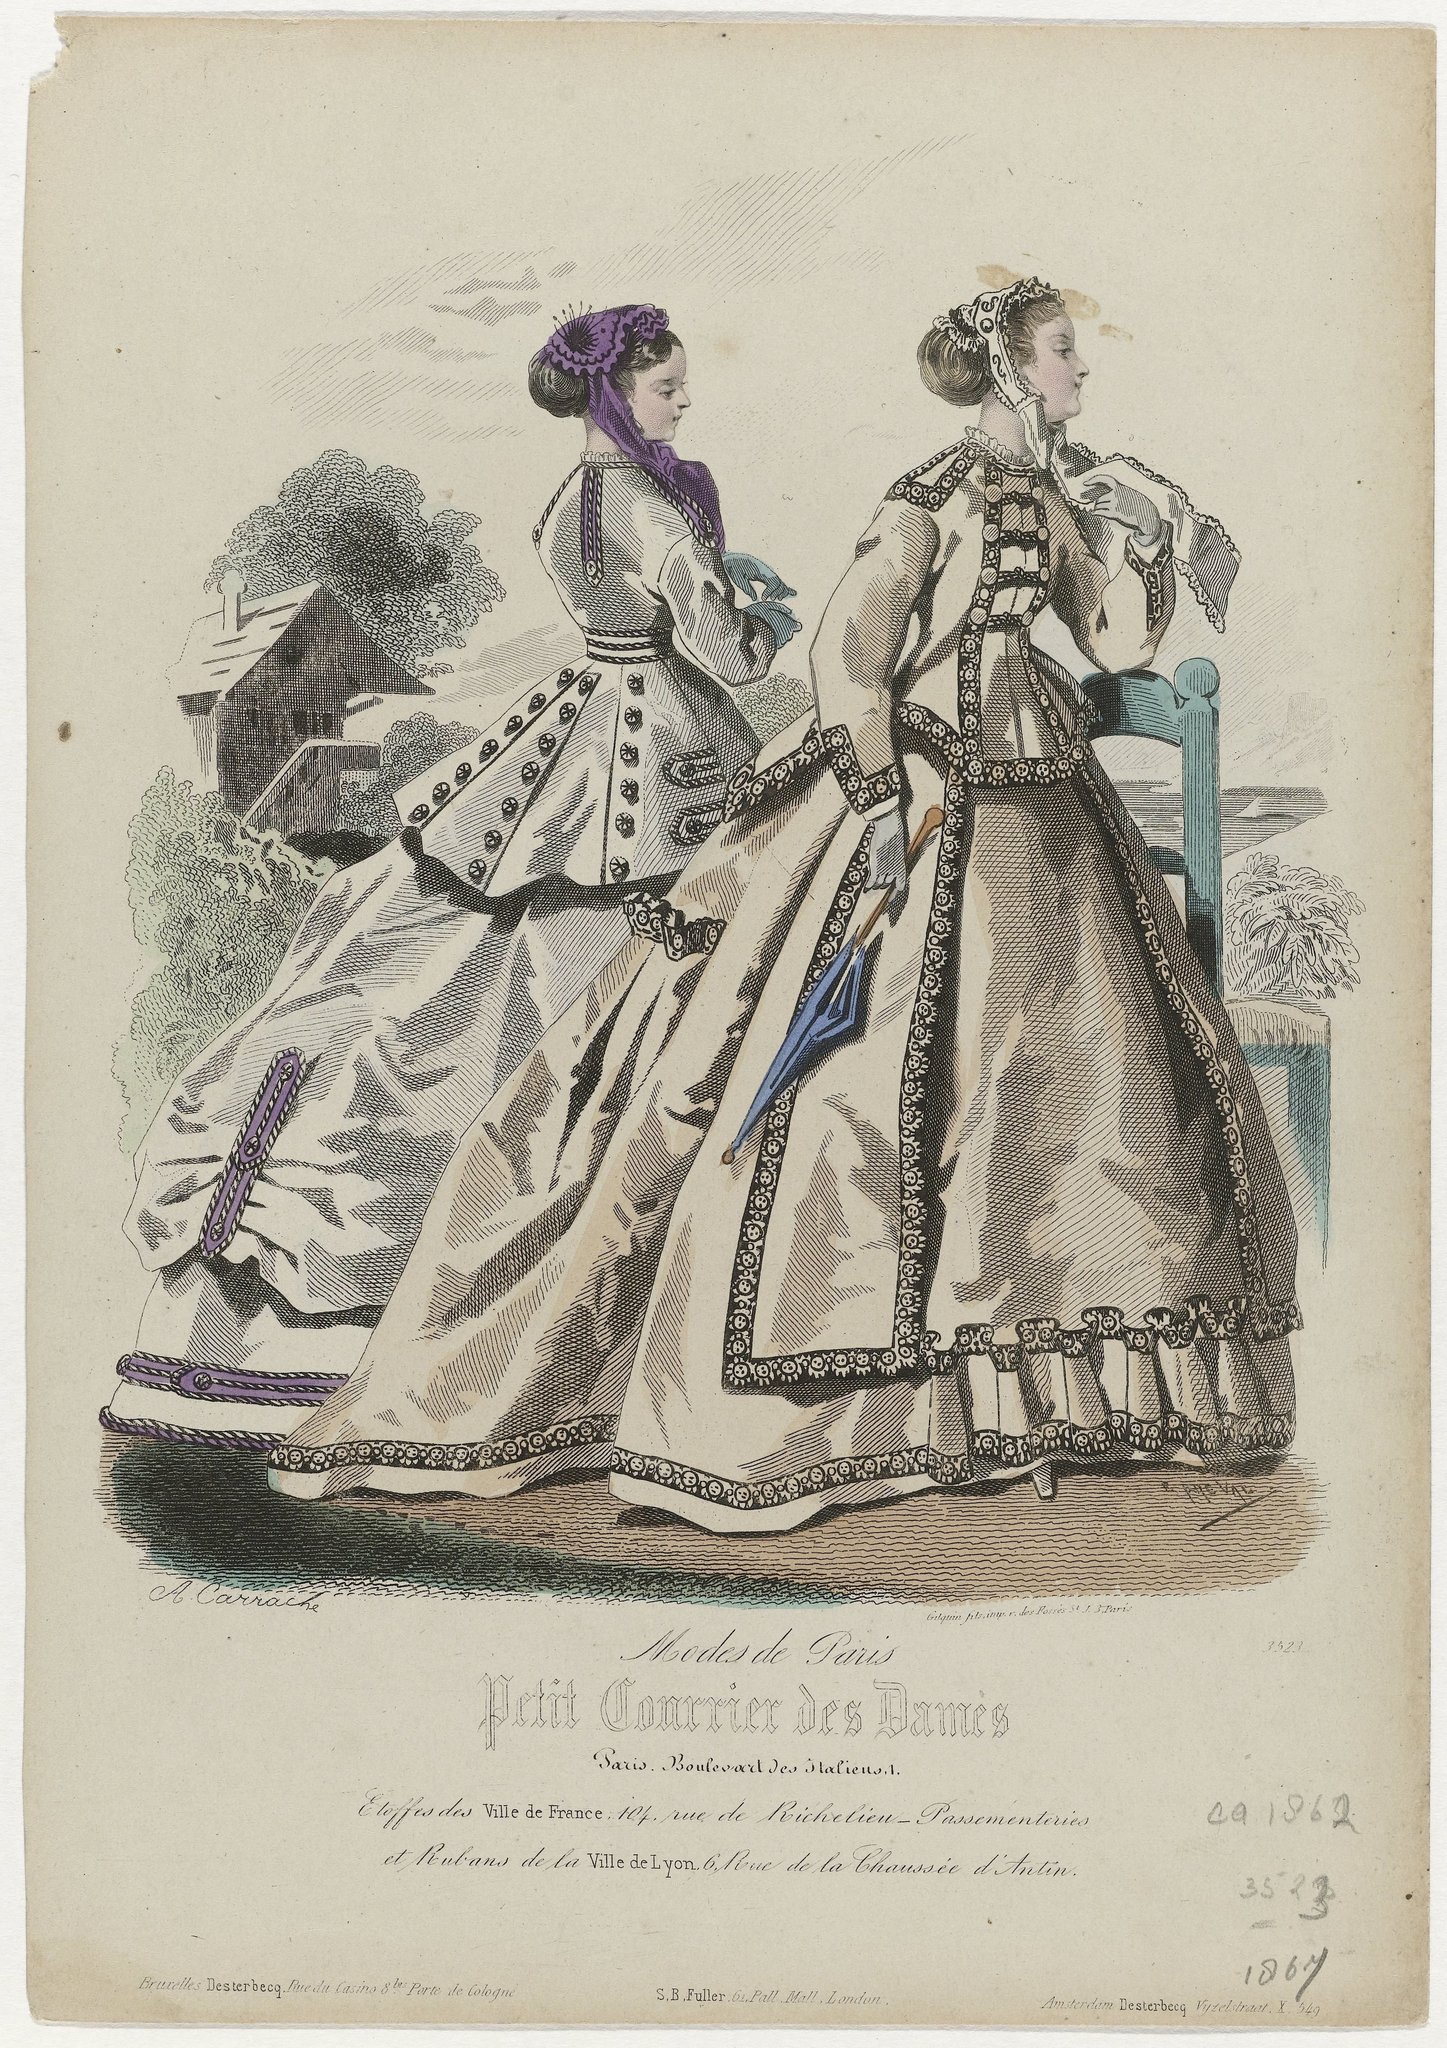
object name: fashion print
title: Petit Courrier des Dames, 1867, No. 3523 : Etoffes des Ville de Franc (...)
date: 1867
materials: paper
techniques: engraving, hand coloring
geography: paris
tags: border, ribbon, braid (+ women's clothes), head-gear (+ women's clothes), fashion plates, gloves, mittens, etc. (+ women's clothes), parasol, sunshade (+ women's clothes)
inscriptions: address: ‘Paris. Boulevart des Italiens 1 / Bruxelles Desterbecq Rue du Casino 8bis Porte de Cologne / S.B. Fuller, 61, Pall Mall, London / Amsterdam Desterbecq Vijzelstraat X 549’, caption: ‘Etoffes des Ville de France. 104. rue de Richelieu _ Passementeries et Rubans de la Ville de Lyon. 6. Rue de la Chaussée d'Antin.’, title: ‘Modes de Paris / Petit Courrier des Dames’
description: Twee vrouwen, van wie één op de rug gezien, in de buitenlucht. Onder de voorstelling enkele regeles reclametekst voor verschillende producten. Prent uit het modetijdschrift Petit Courrier des Dames (1821-1868).